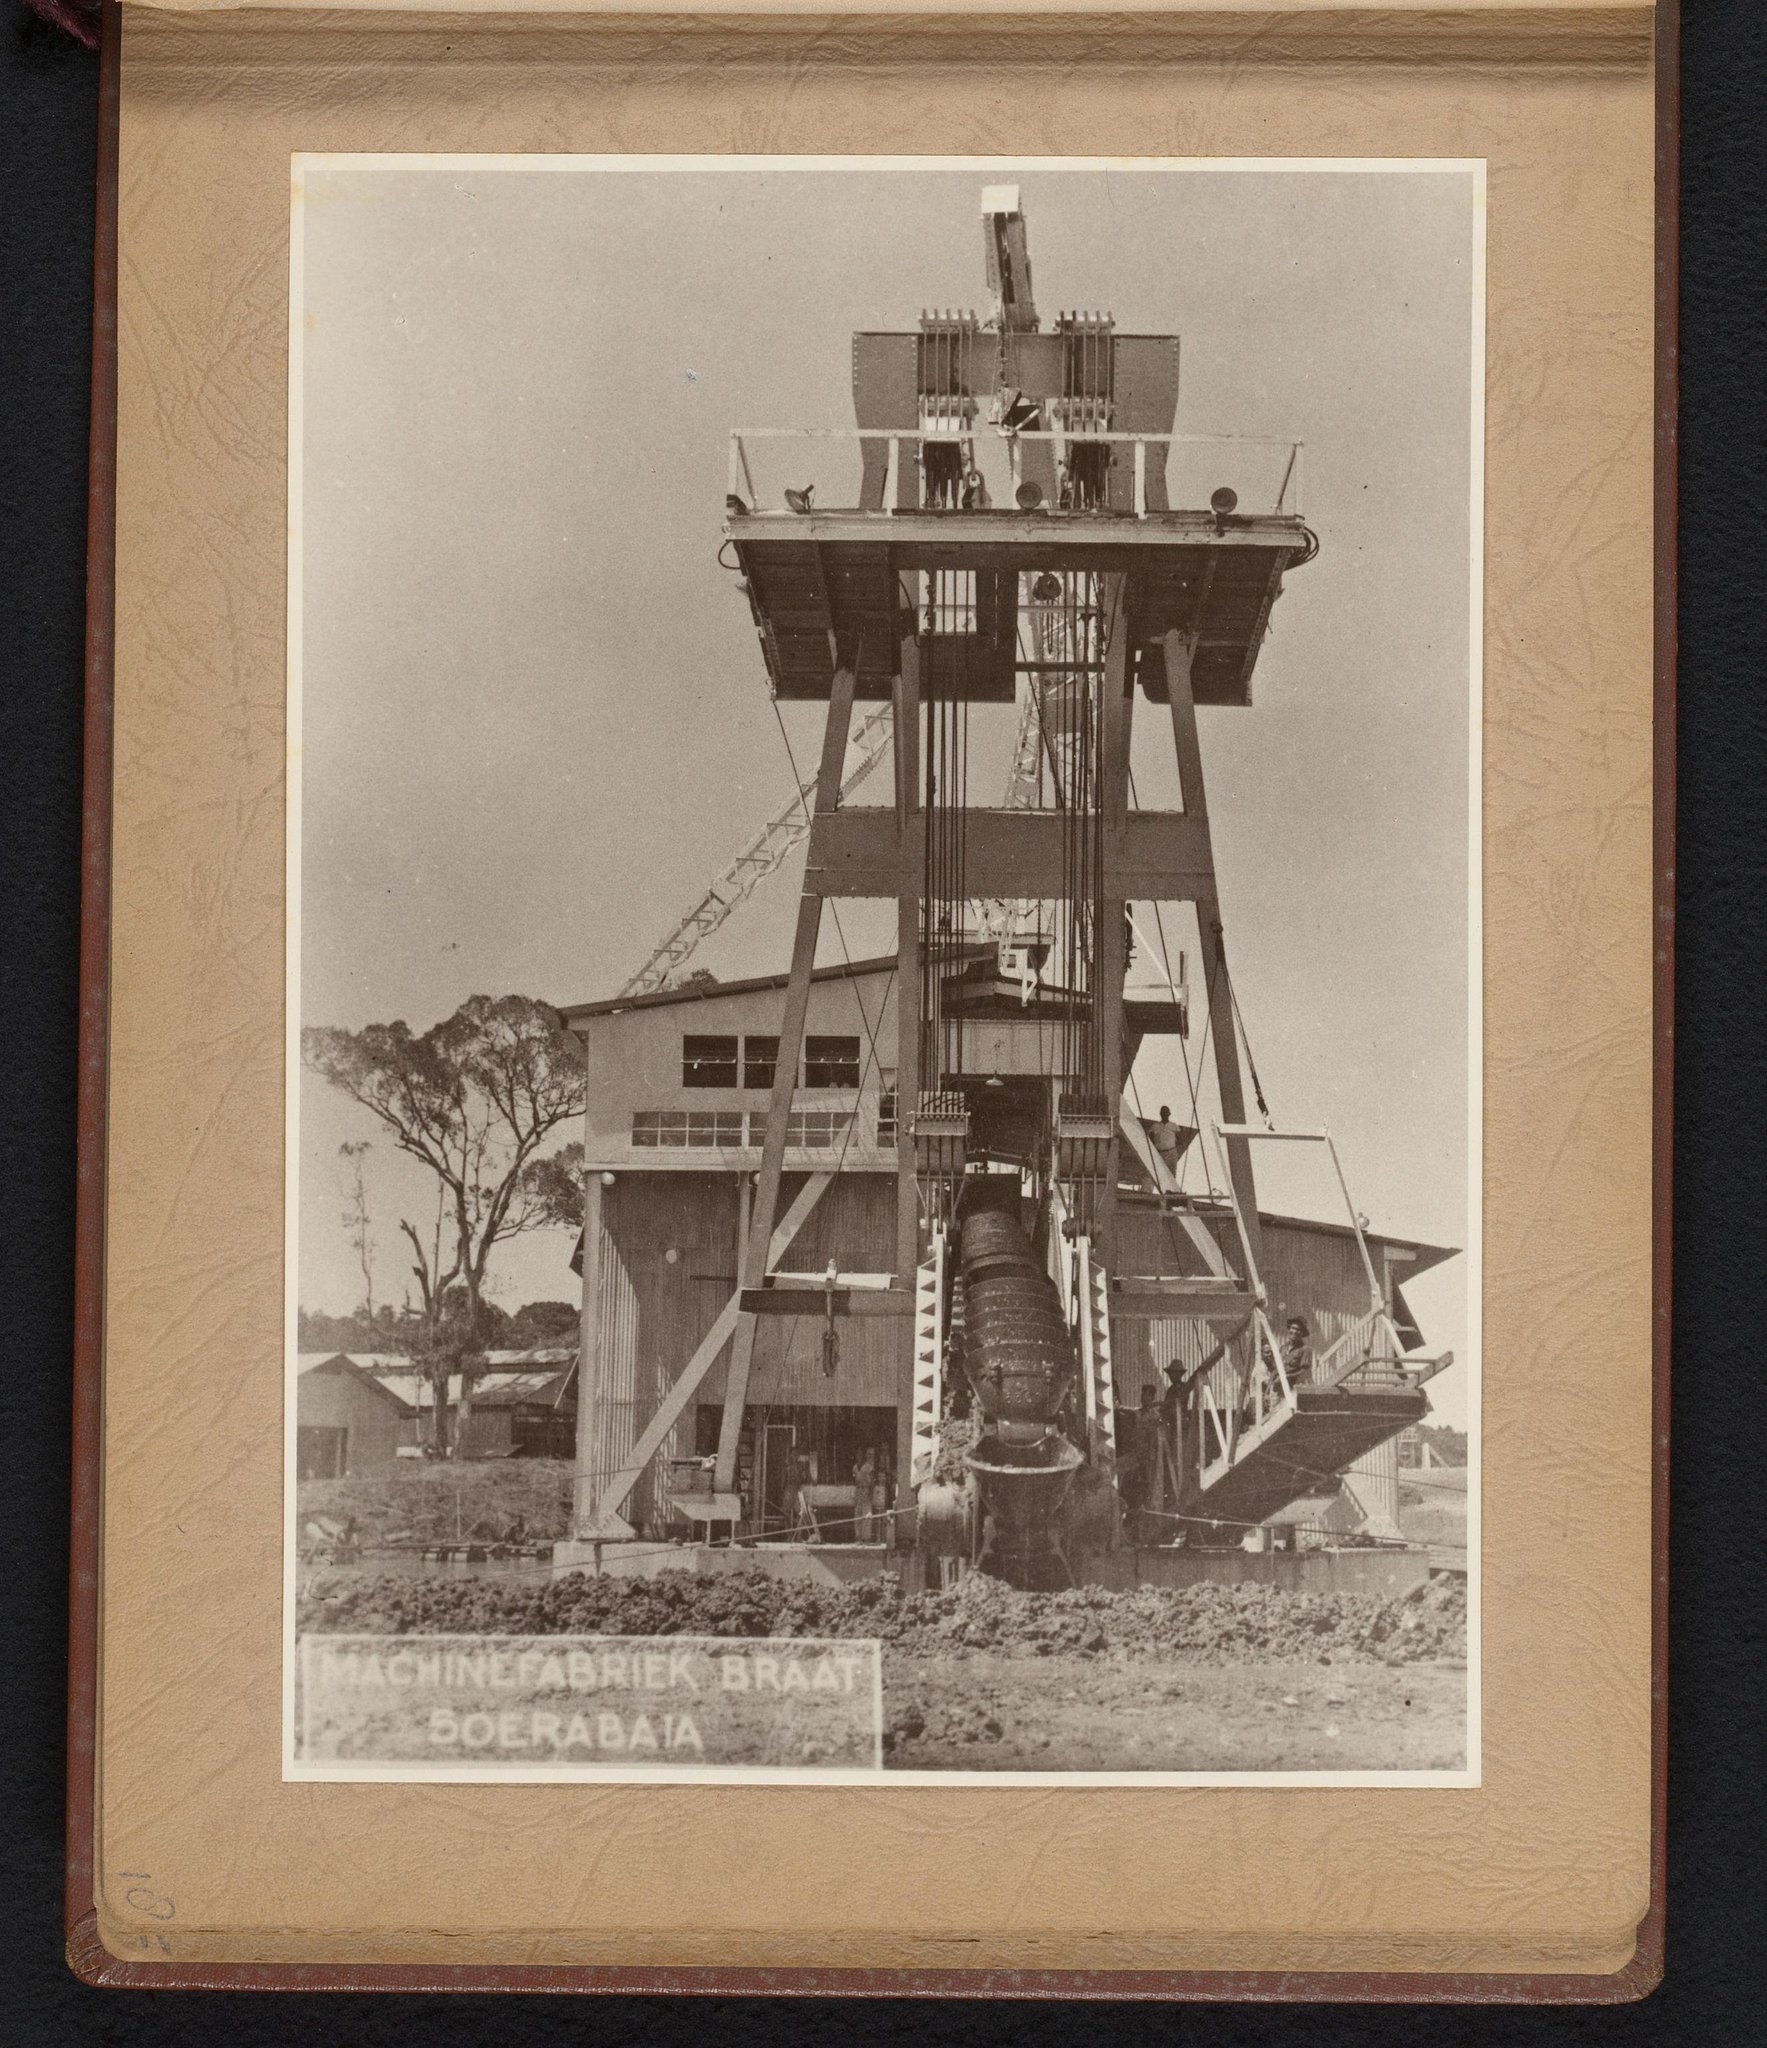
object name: album leaf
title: Rubbermangels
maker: Anonymous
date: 1936-1950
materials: cardboard, photographic support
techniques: gelatin silver print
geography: surabaya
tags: factory-interior, machine shop, machines; parts of machines; tools and appliances, java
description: Albumblad met een foto van een loods met rubbermangels, machines voor gebruik in de rubberindustrie. Onderdeel van het fotoalbum van de N.V. Machinefabriek Braat te Soerabaja met foto's van verschillende producten voor de industrie uit de periode 1936-1953.